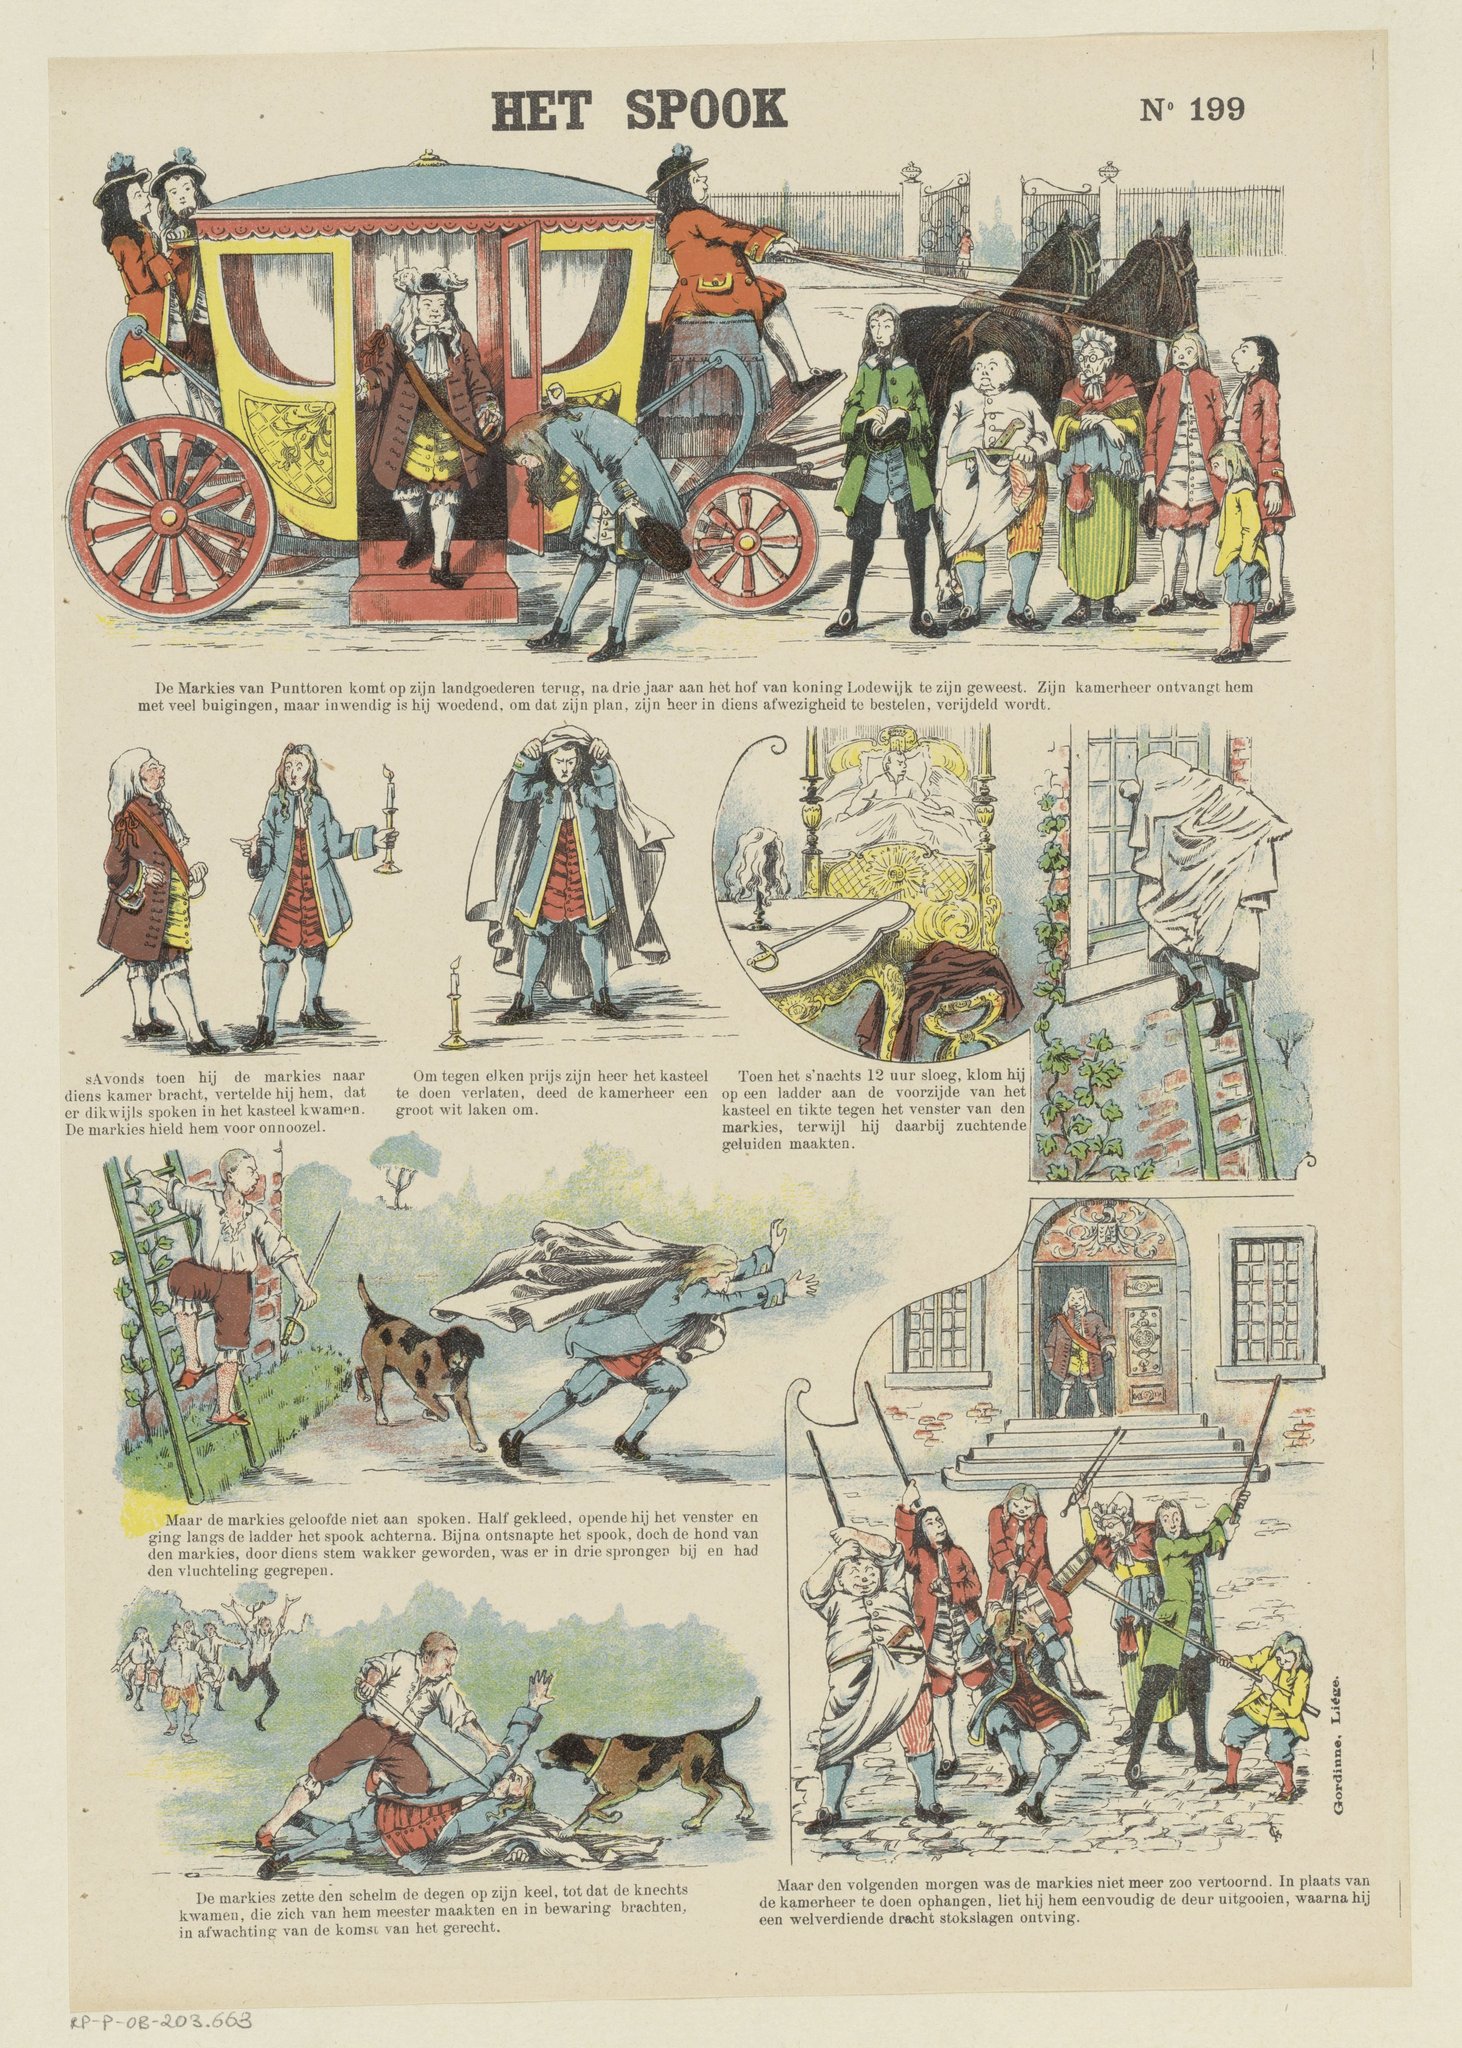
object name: print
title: Het spook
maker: monogrammist jgr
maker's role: print maker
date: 1894-1959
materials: paper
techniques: lithograph, letterpress printing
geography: liège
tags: spirit, ghost, nobility and patriciate; chivalry, knighthood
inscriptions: collector's mark: Lugt 2760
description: Blad met 7 voorstellingen over de kamerheer van de markies van Punttoren die zich voordoet als een spook. Onder elke afbeelding een onderschrift. Genummerd rechtsboven: No 199.